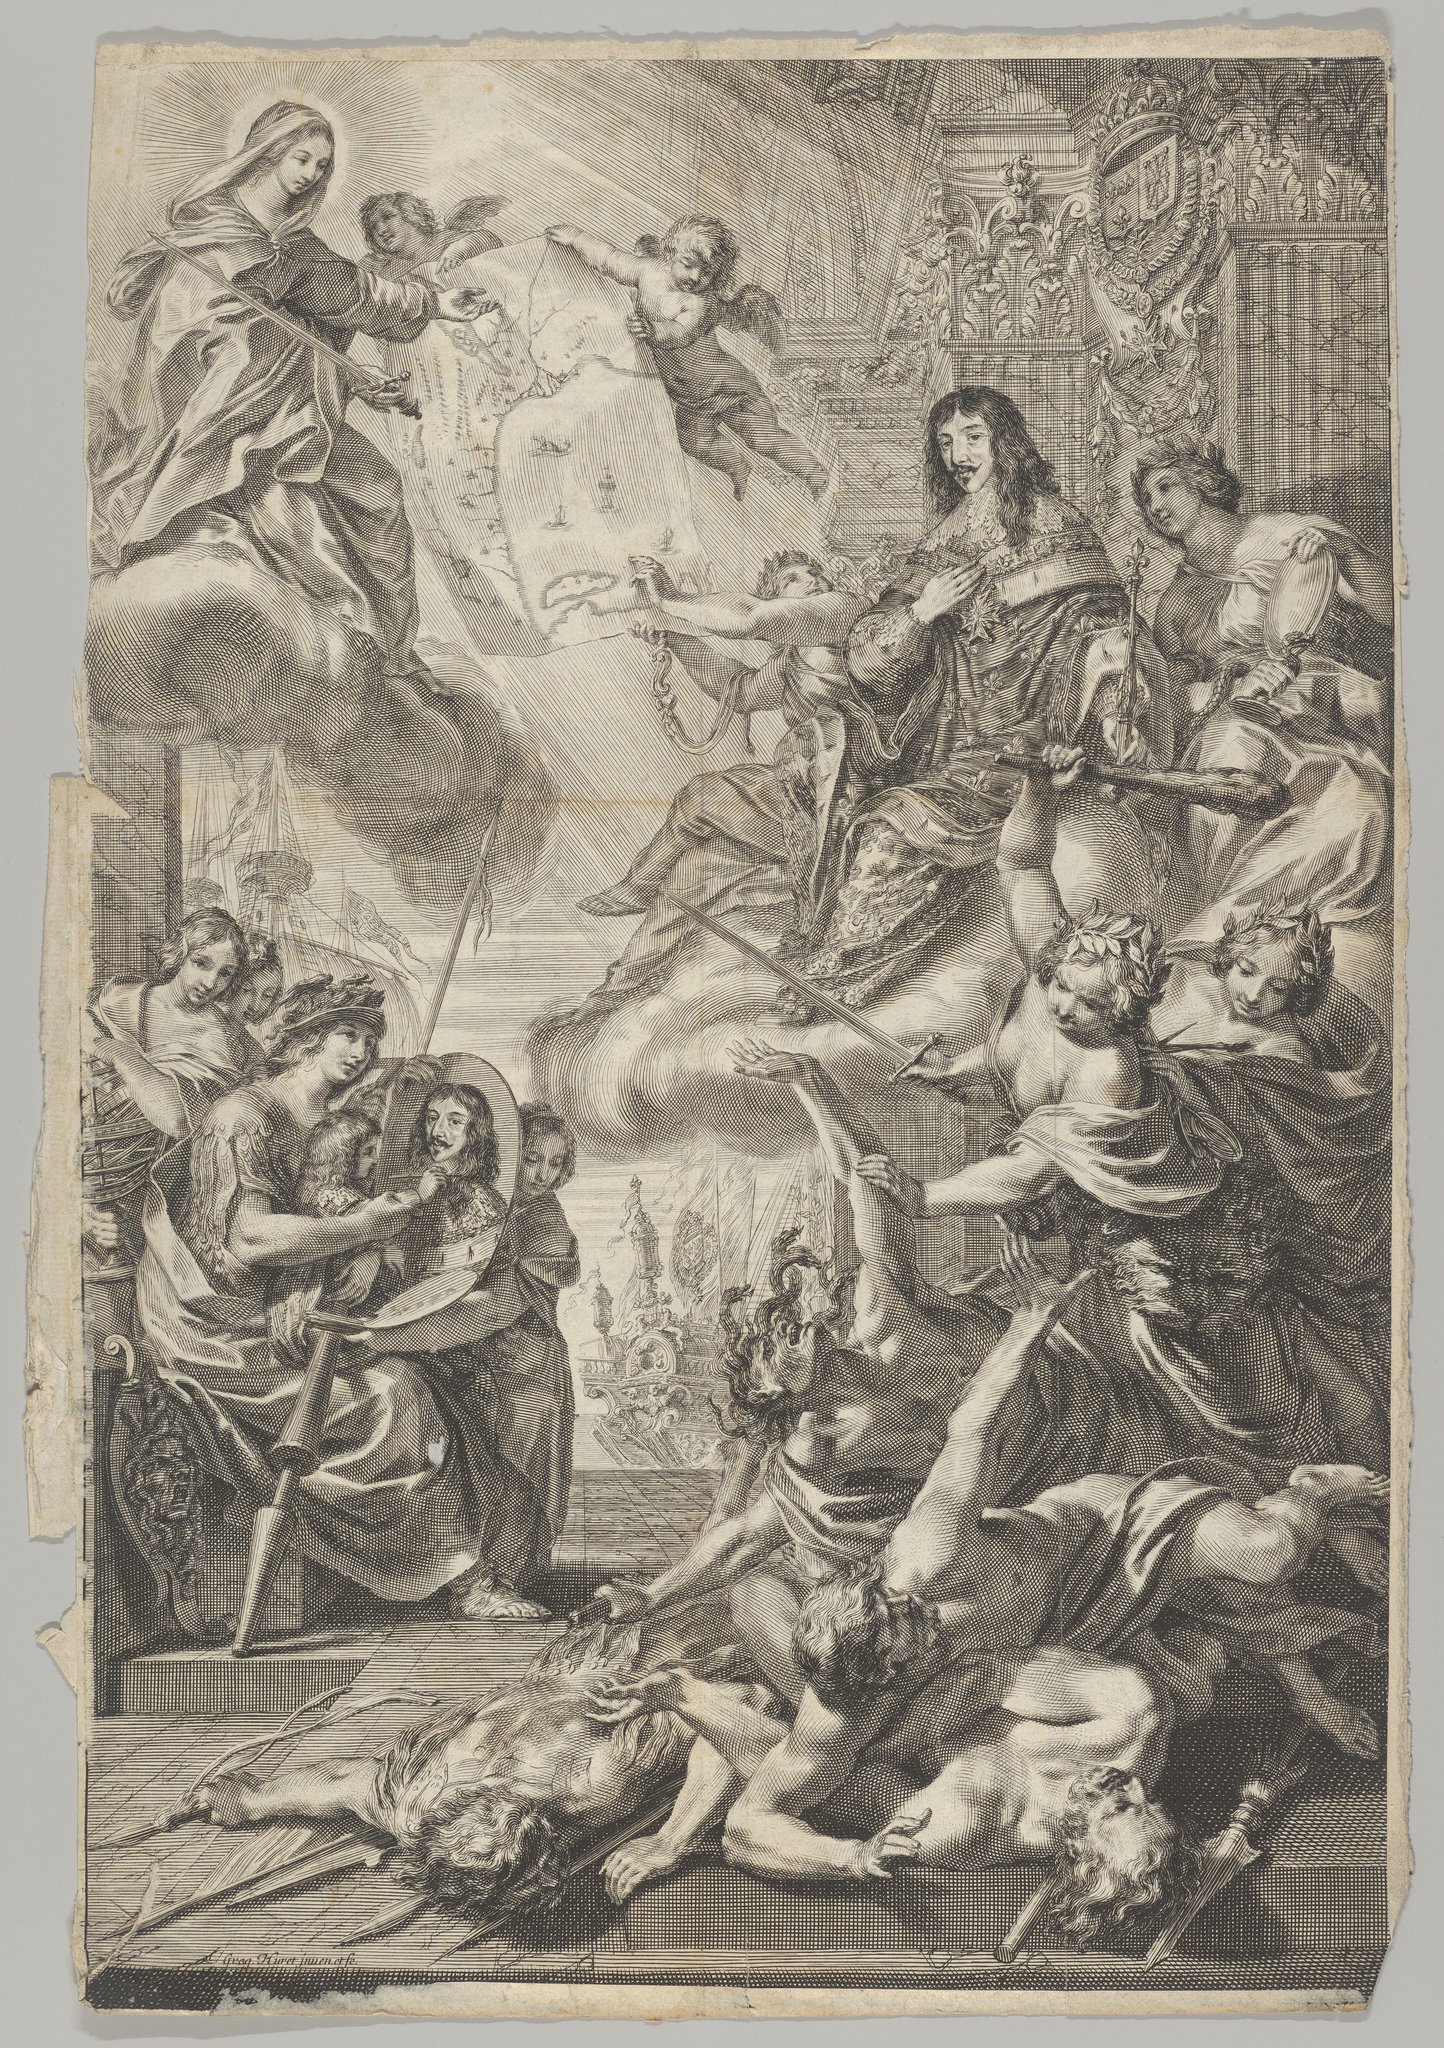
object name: print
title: Virgin Helps Louis XIII to Expel the Vices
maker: grégoire huret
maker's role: artist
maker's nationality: french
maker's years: 1606-1670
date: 1601-1700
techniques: engraving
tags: swords,men,women,angels,virgin mary